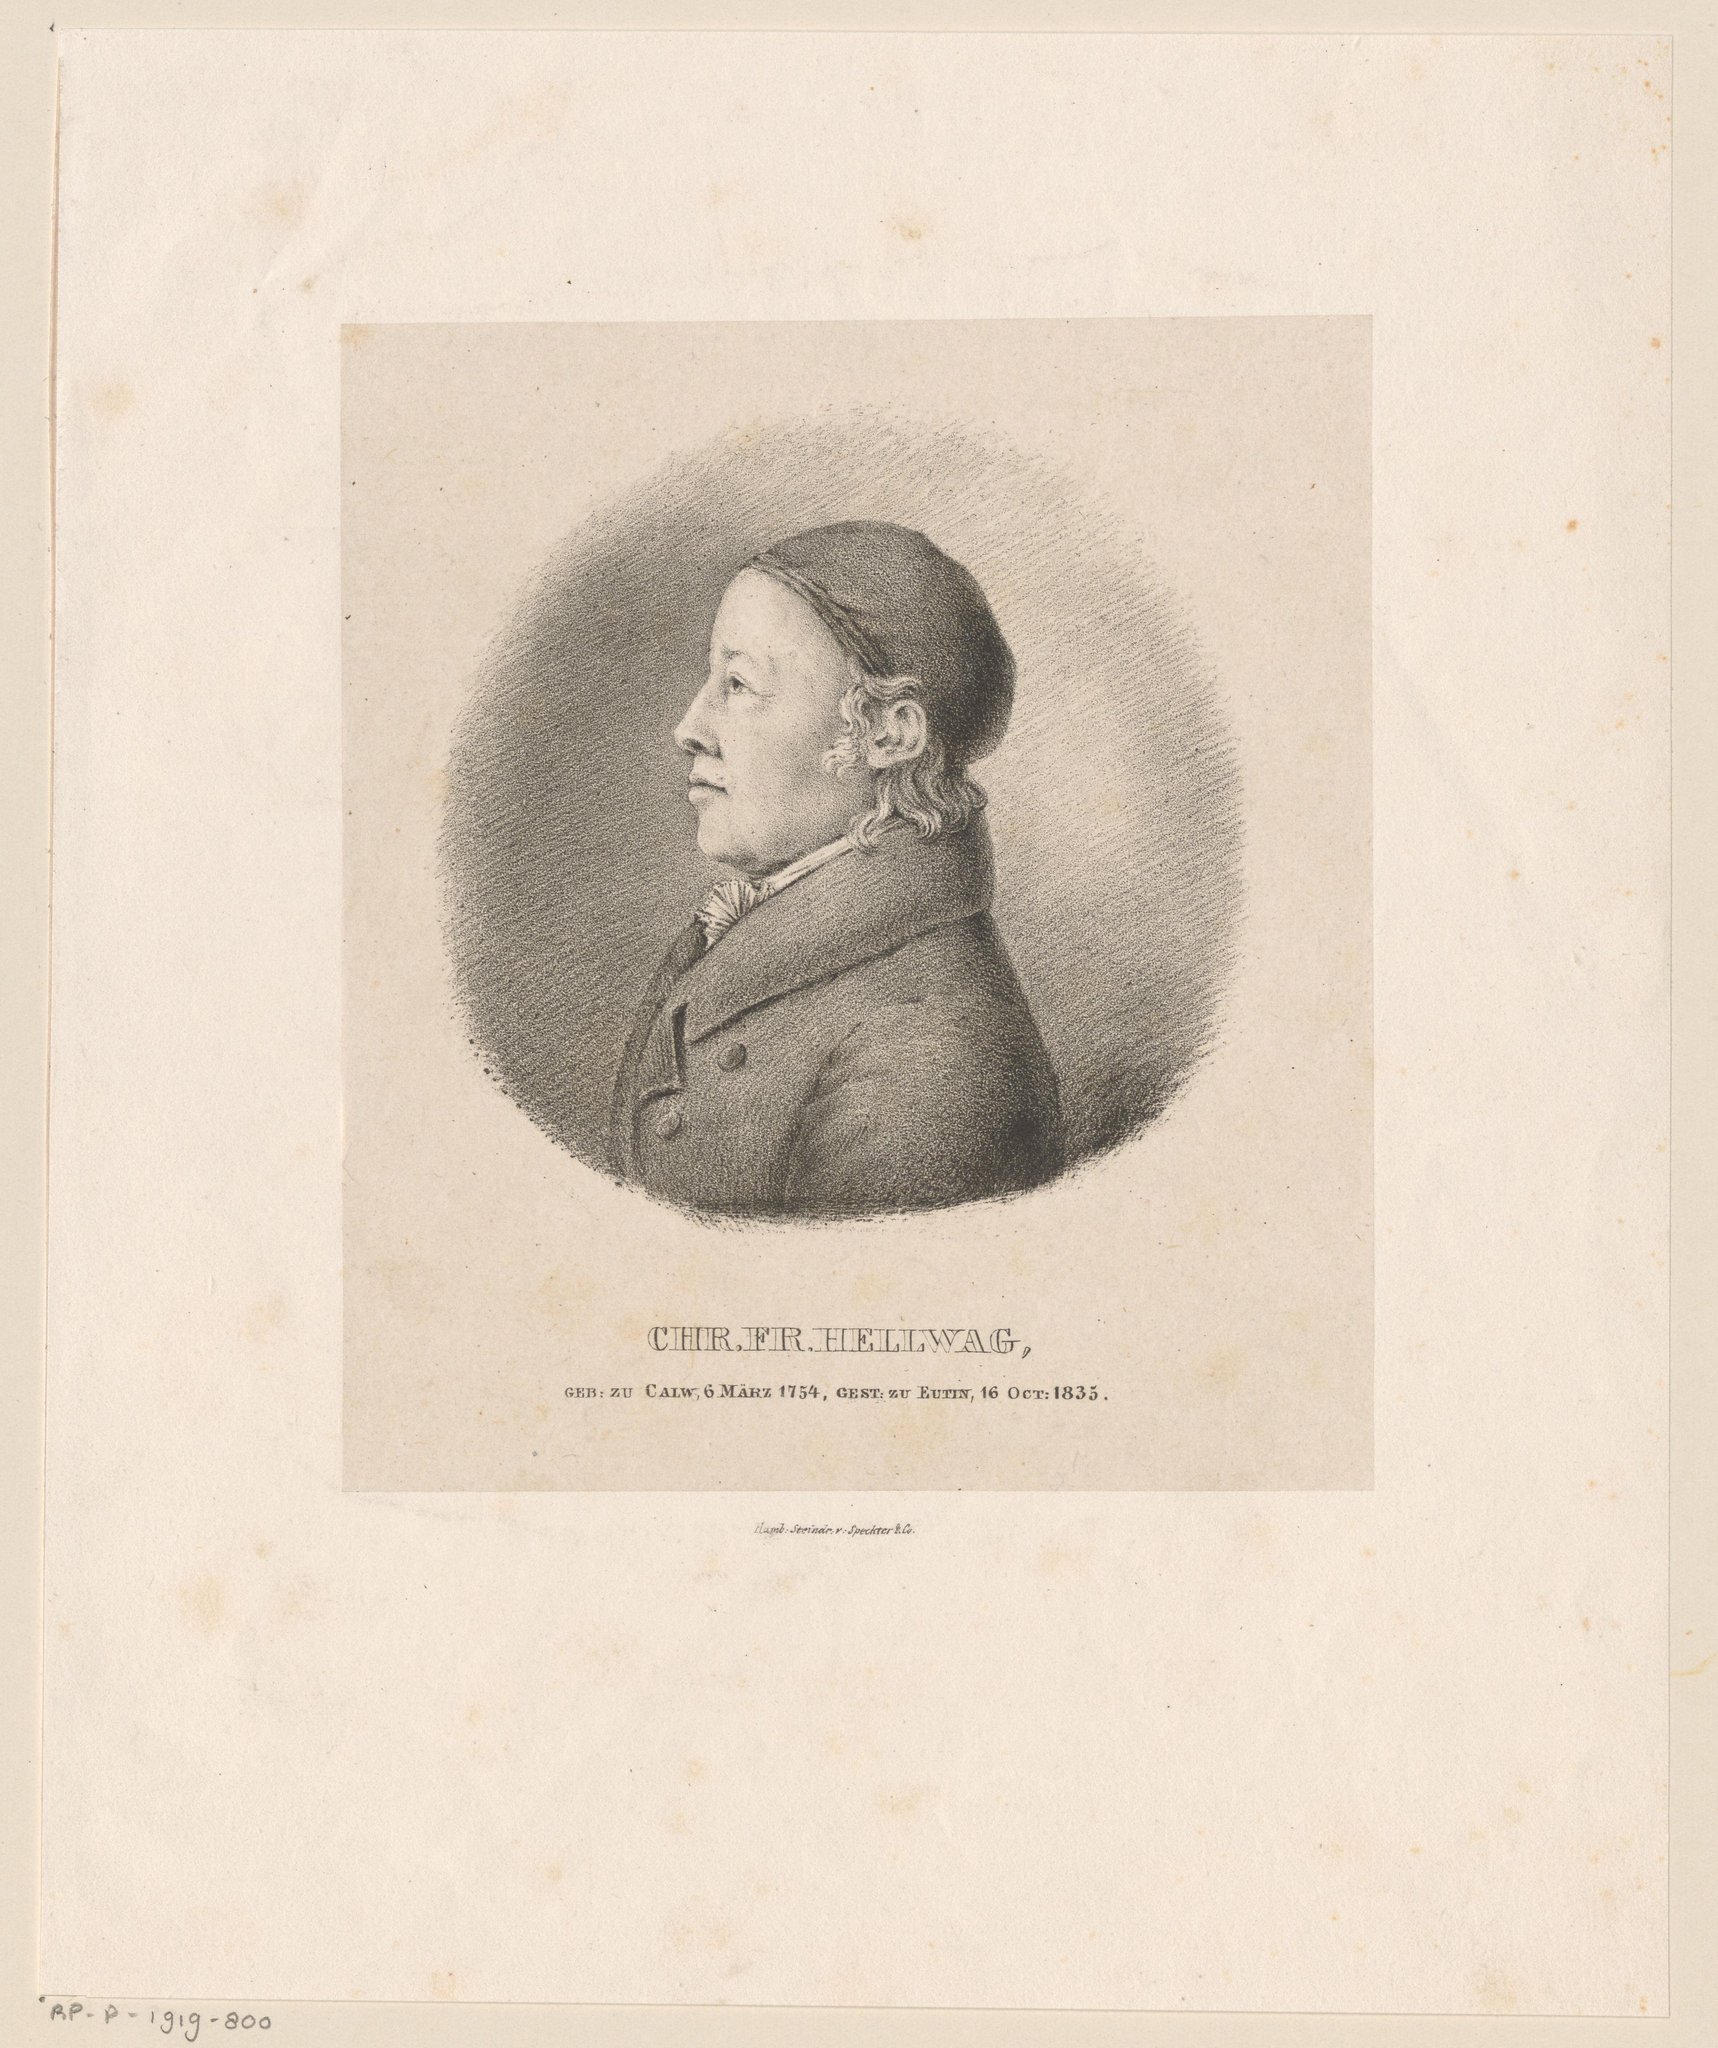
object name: print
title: Portret van Christoph Friedrich Hellwag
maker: Anonymous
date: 1820-1885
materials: paper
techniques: lithograph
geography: hamburg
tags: historical persons, physician, doctor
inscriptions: collector's mark: Lugt 2228